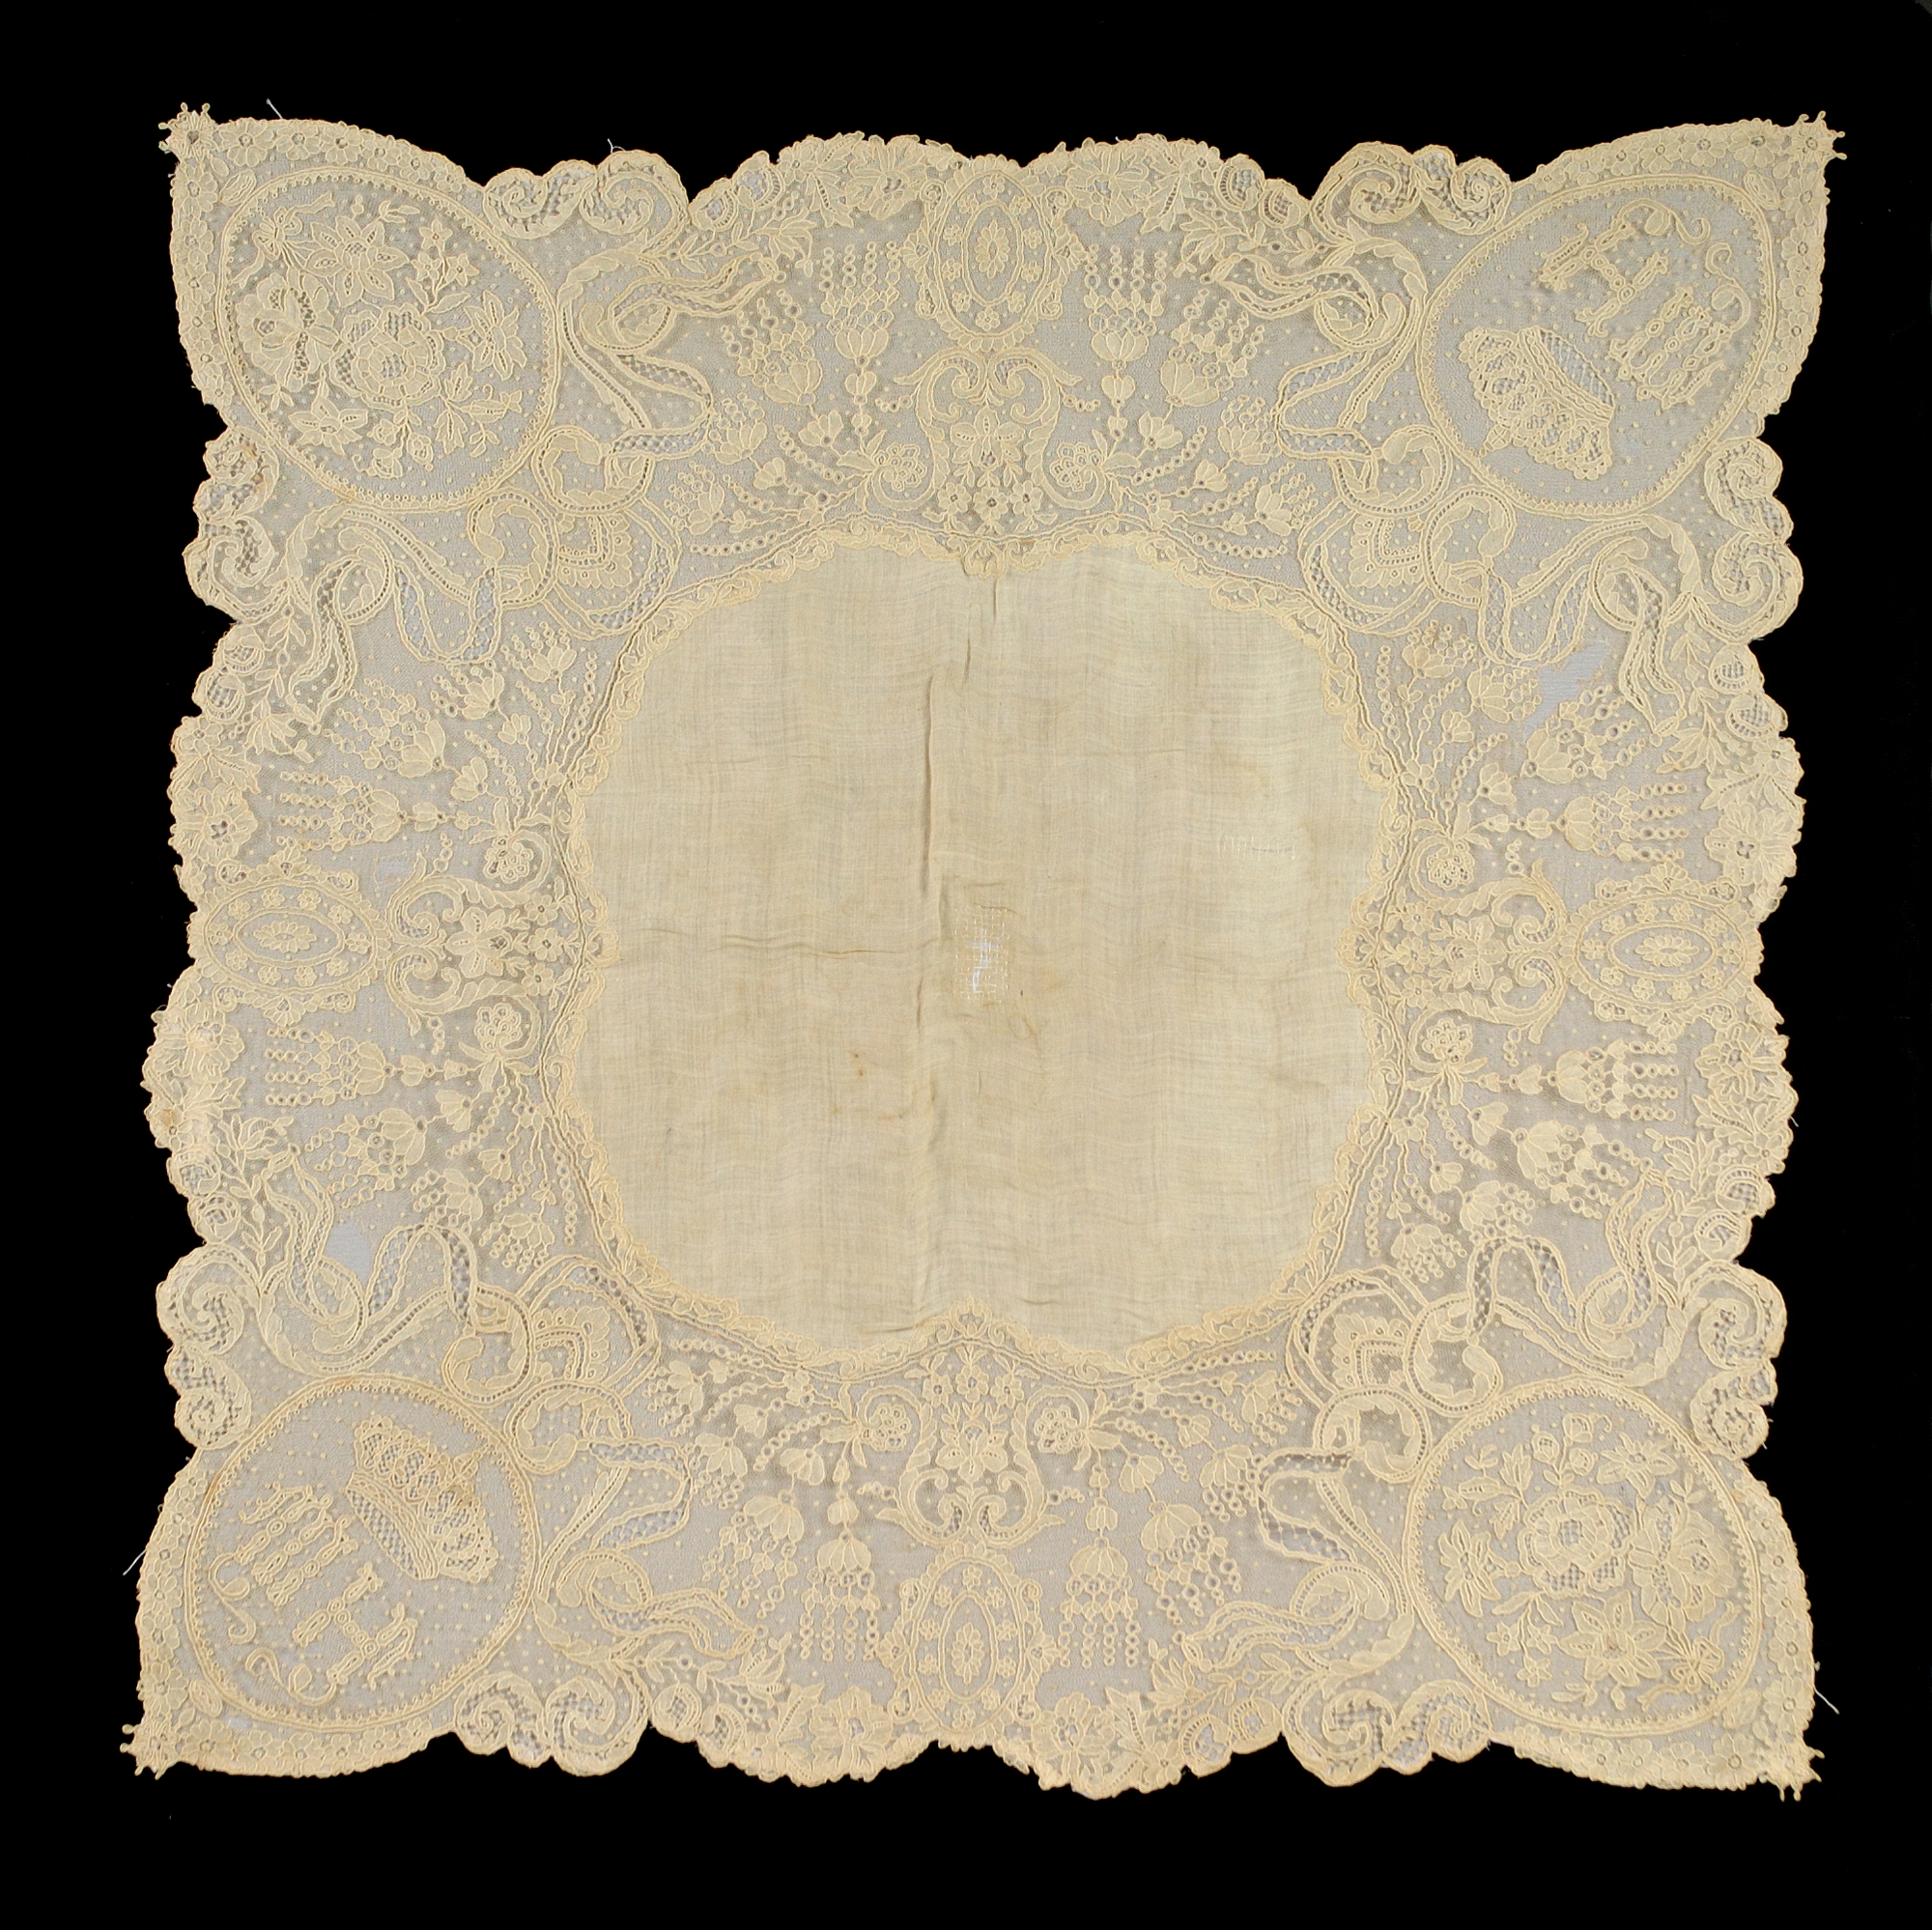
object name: handkerchief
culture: belgian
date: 1851-1875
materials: linen